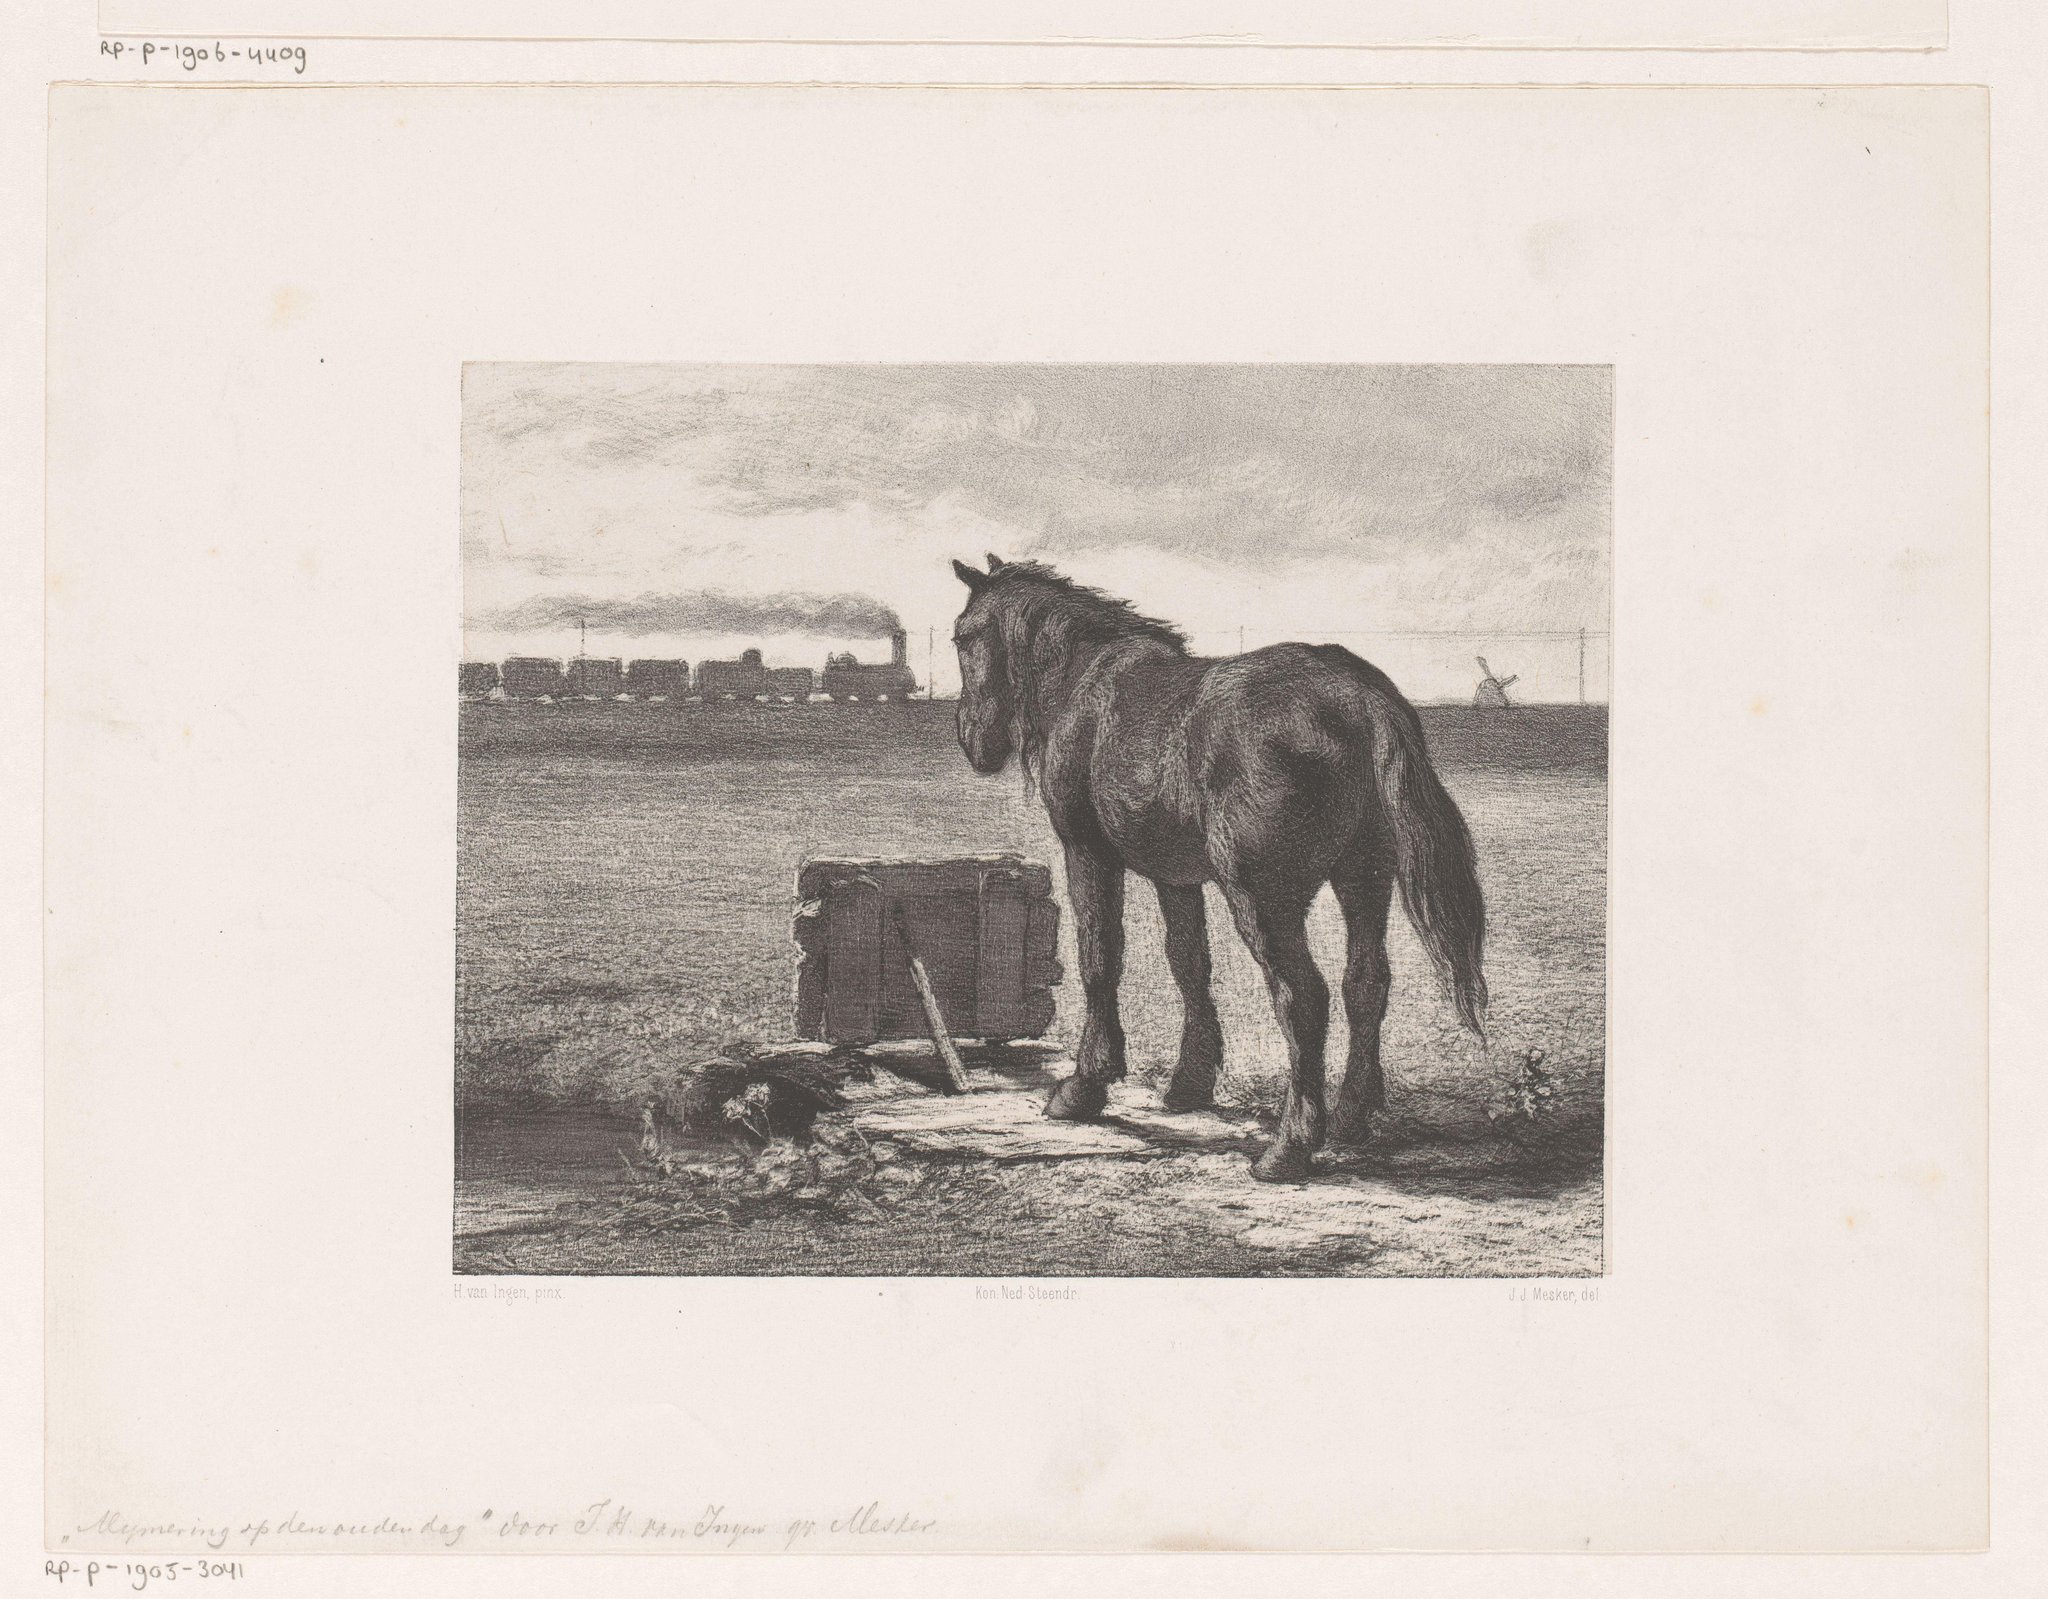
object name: print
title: Paard in weiland met stoomtrein aan de horizon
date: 1867-1874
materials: paper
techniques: lithograph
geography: the hague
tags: horses and kindred animals, windmill, meadow, pasture (+ landscape with figures, staffage), steam locomotive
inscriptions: inscription: ‘"Mijmering op den ouden dag" door J. H. van Ingen gr Mesker’, collector's mark: Lugt 2228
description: Het paard staat achter een houten schot. Rechts aan de horizon een windmolen.